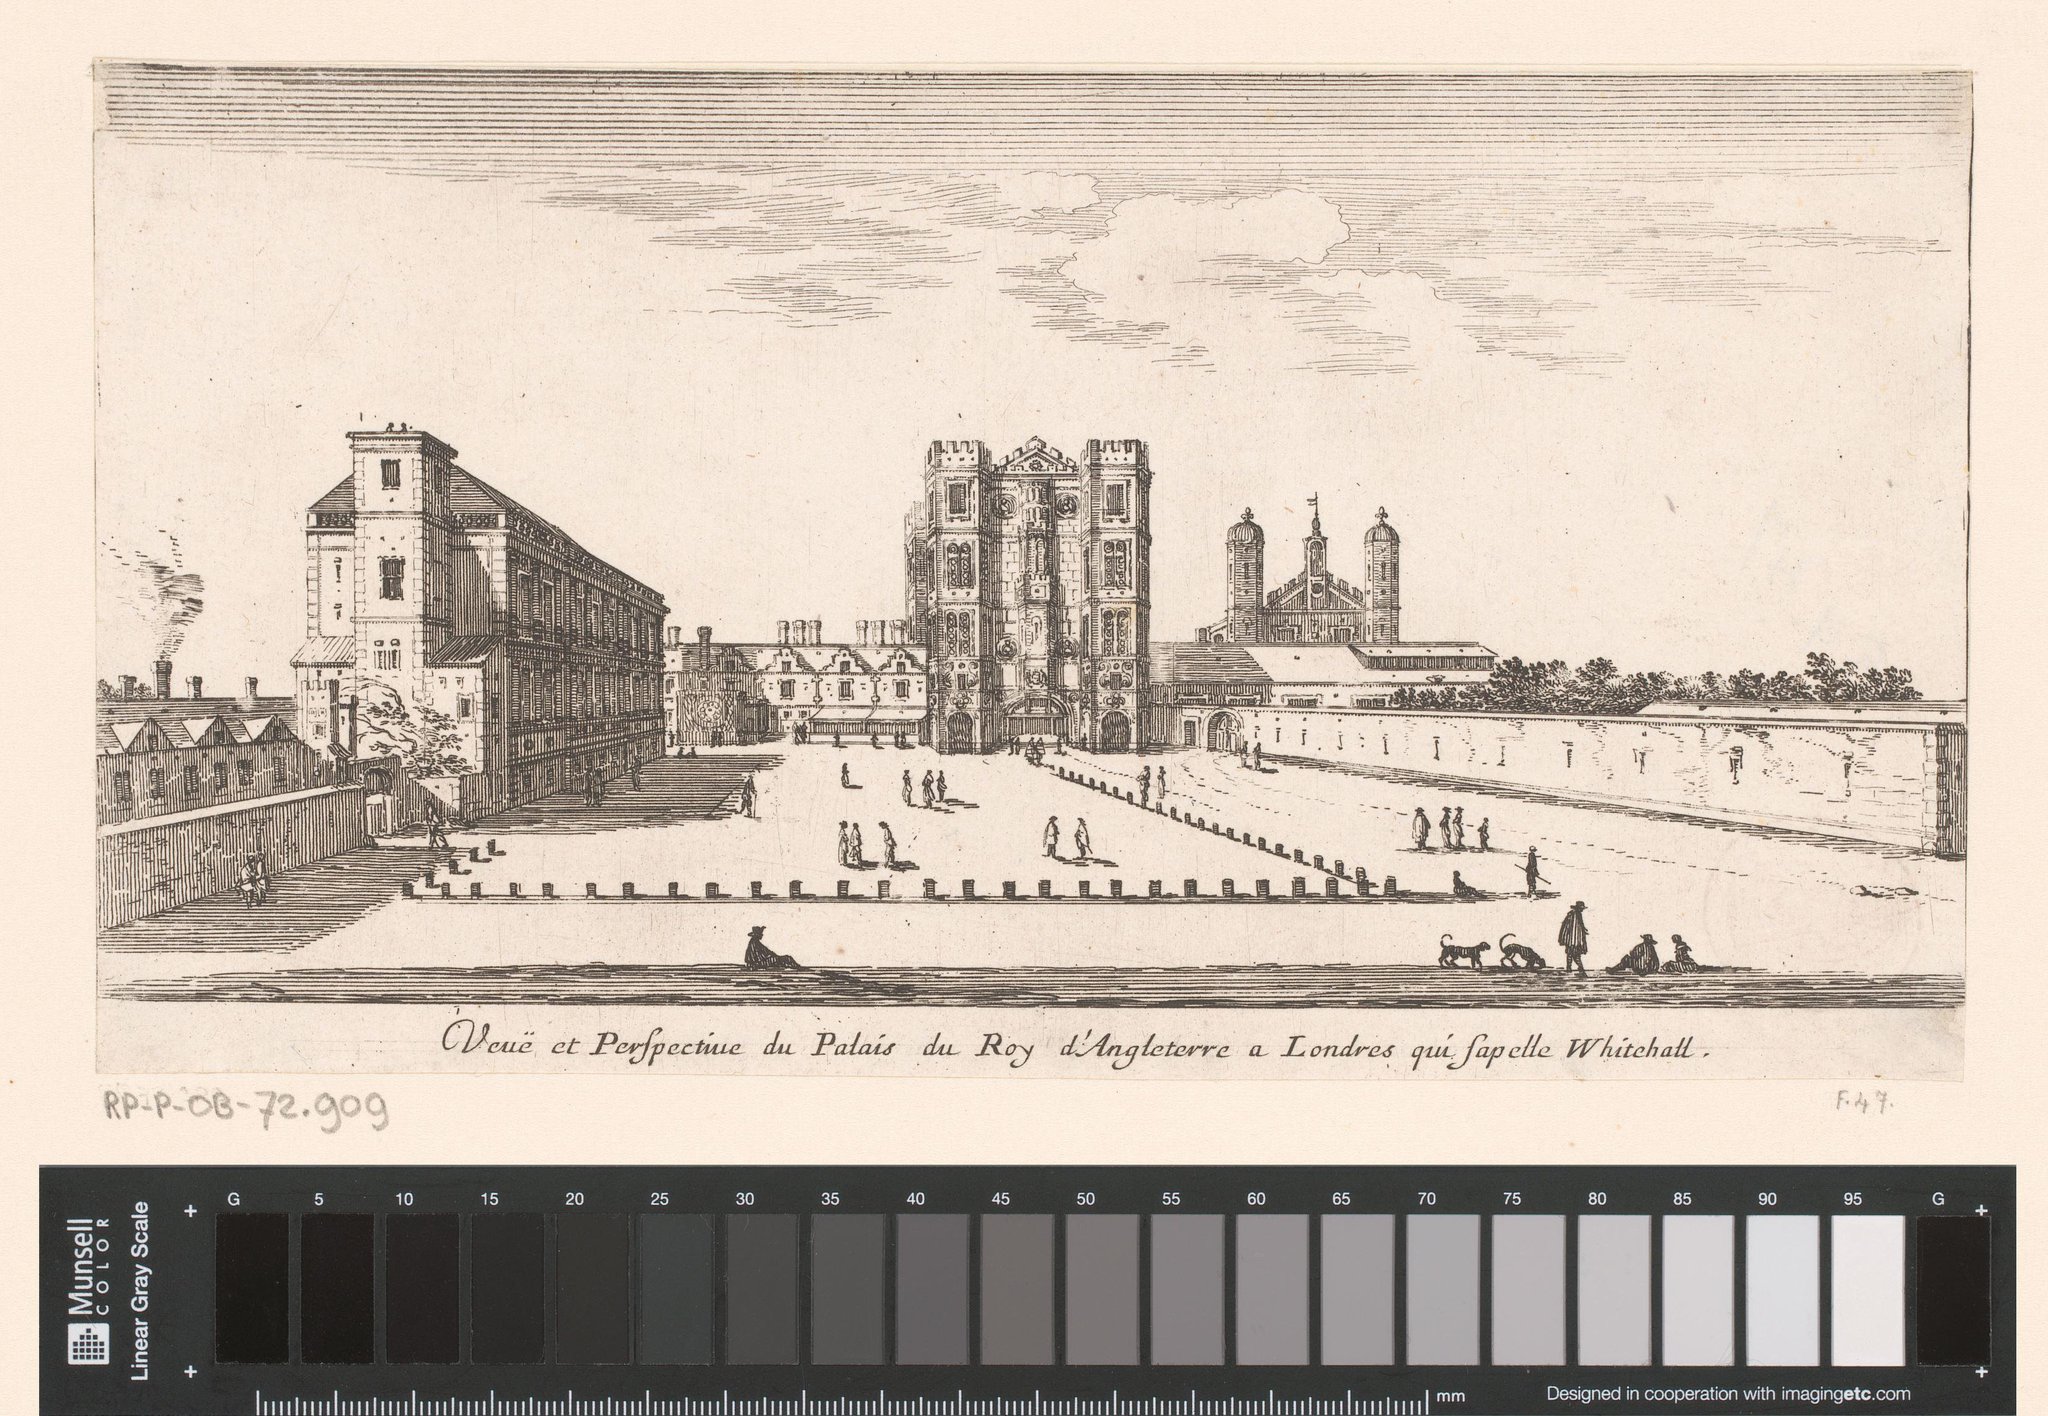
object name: print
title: Veue et Perspective du Palais du Roy d'Angleterre a Londres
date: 1631-1661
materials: paper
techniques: engraving, etching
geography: france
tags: landscape with tower or castle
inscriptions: collector's mark: Lugt 240